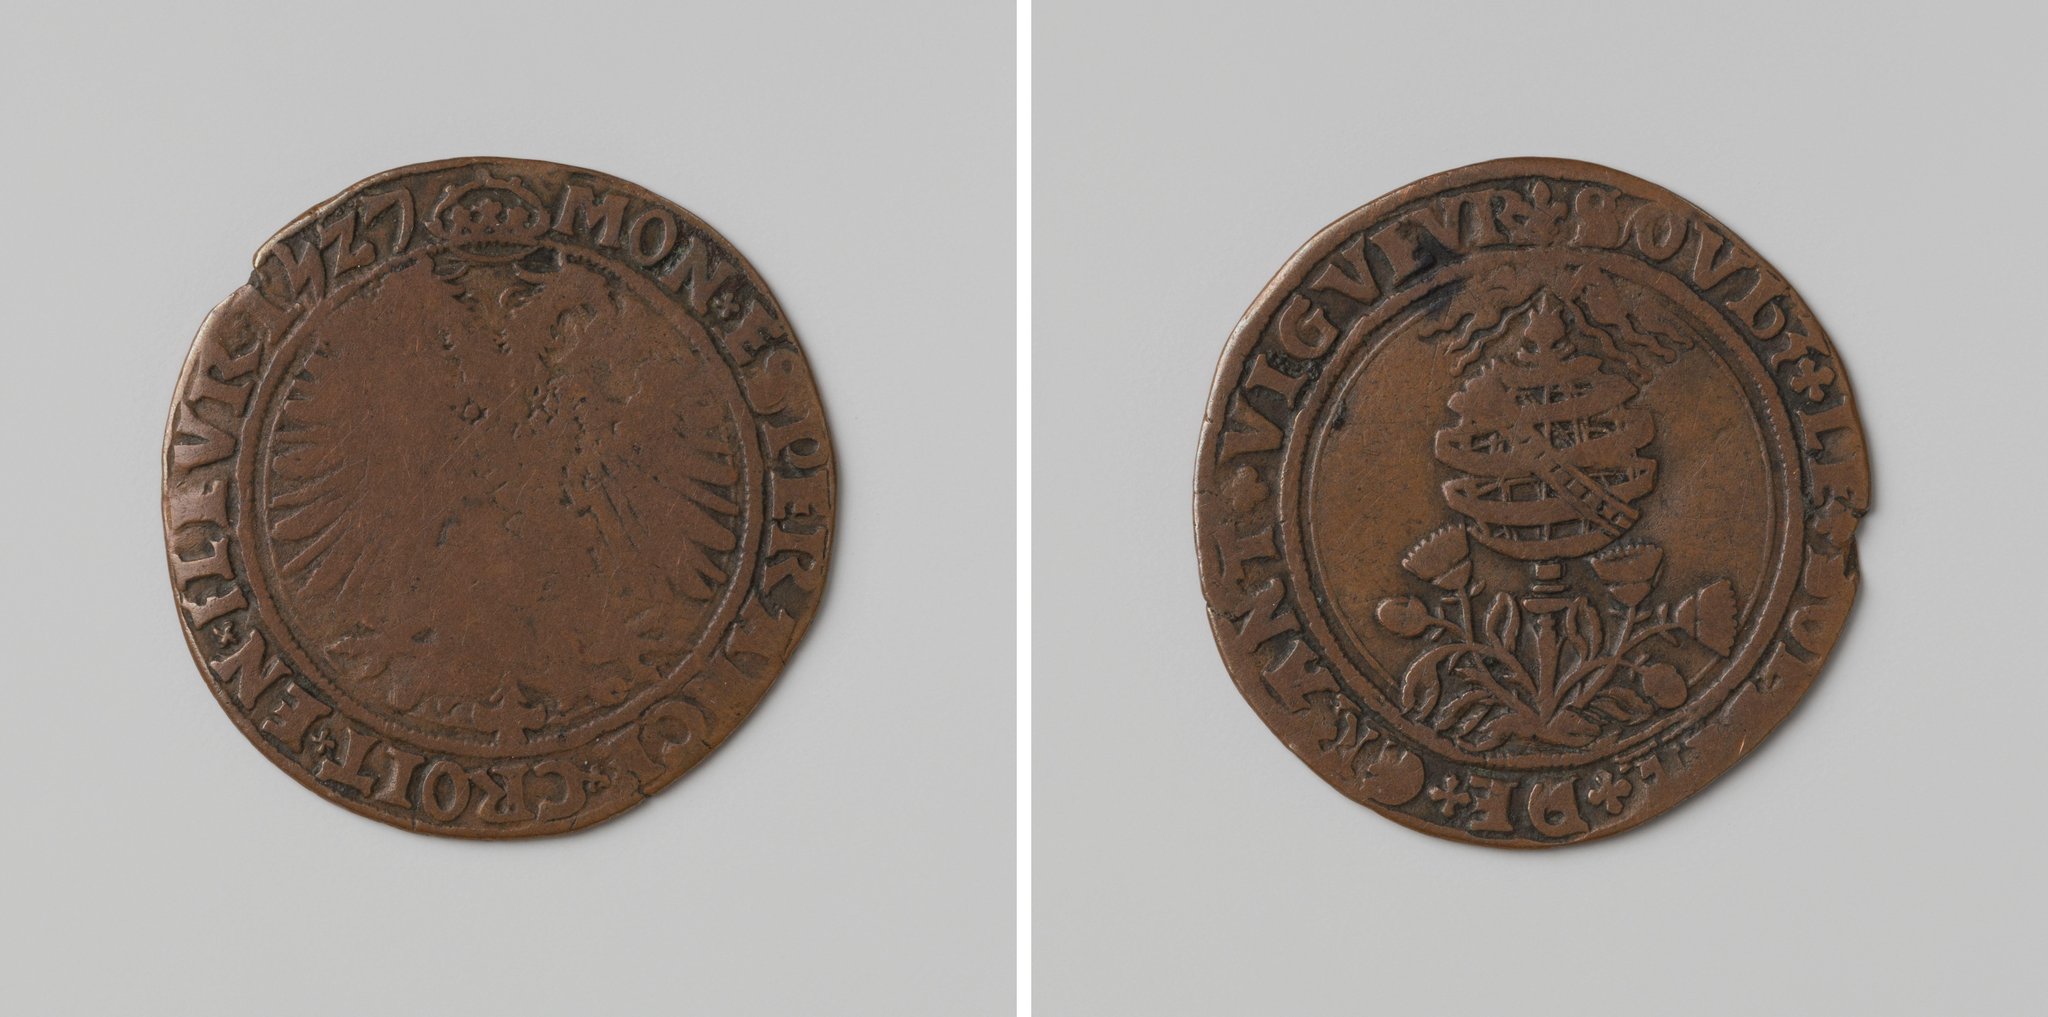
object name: jeton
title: Geboorte van Filips, zoon van Karel V, rekenpenning geslagen op last van Margaretha van Oostenrijk, landvoogdes der Nederlanden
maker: Anonymous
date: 1527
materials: copper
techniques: striking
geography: netherlands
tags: philip ii of spain, brussels, mechelen, ghent, charles v (holy roman emperor and king of spain)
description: Koperen penning. Voorzijde: tweekoppige adelaar onder kroon binnen omschrift. Keerzijde: wereldbol boven bouquet margrieten, beschen door hemellicht binnen omschrift